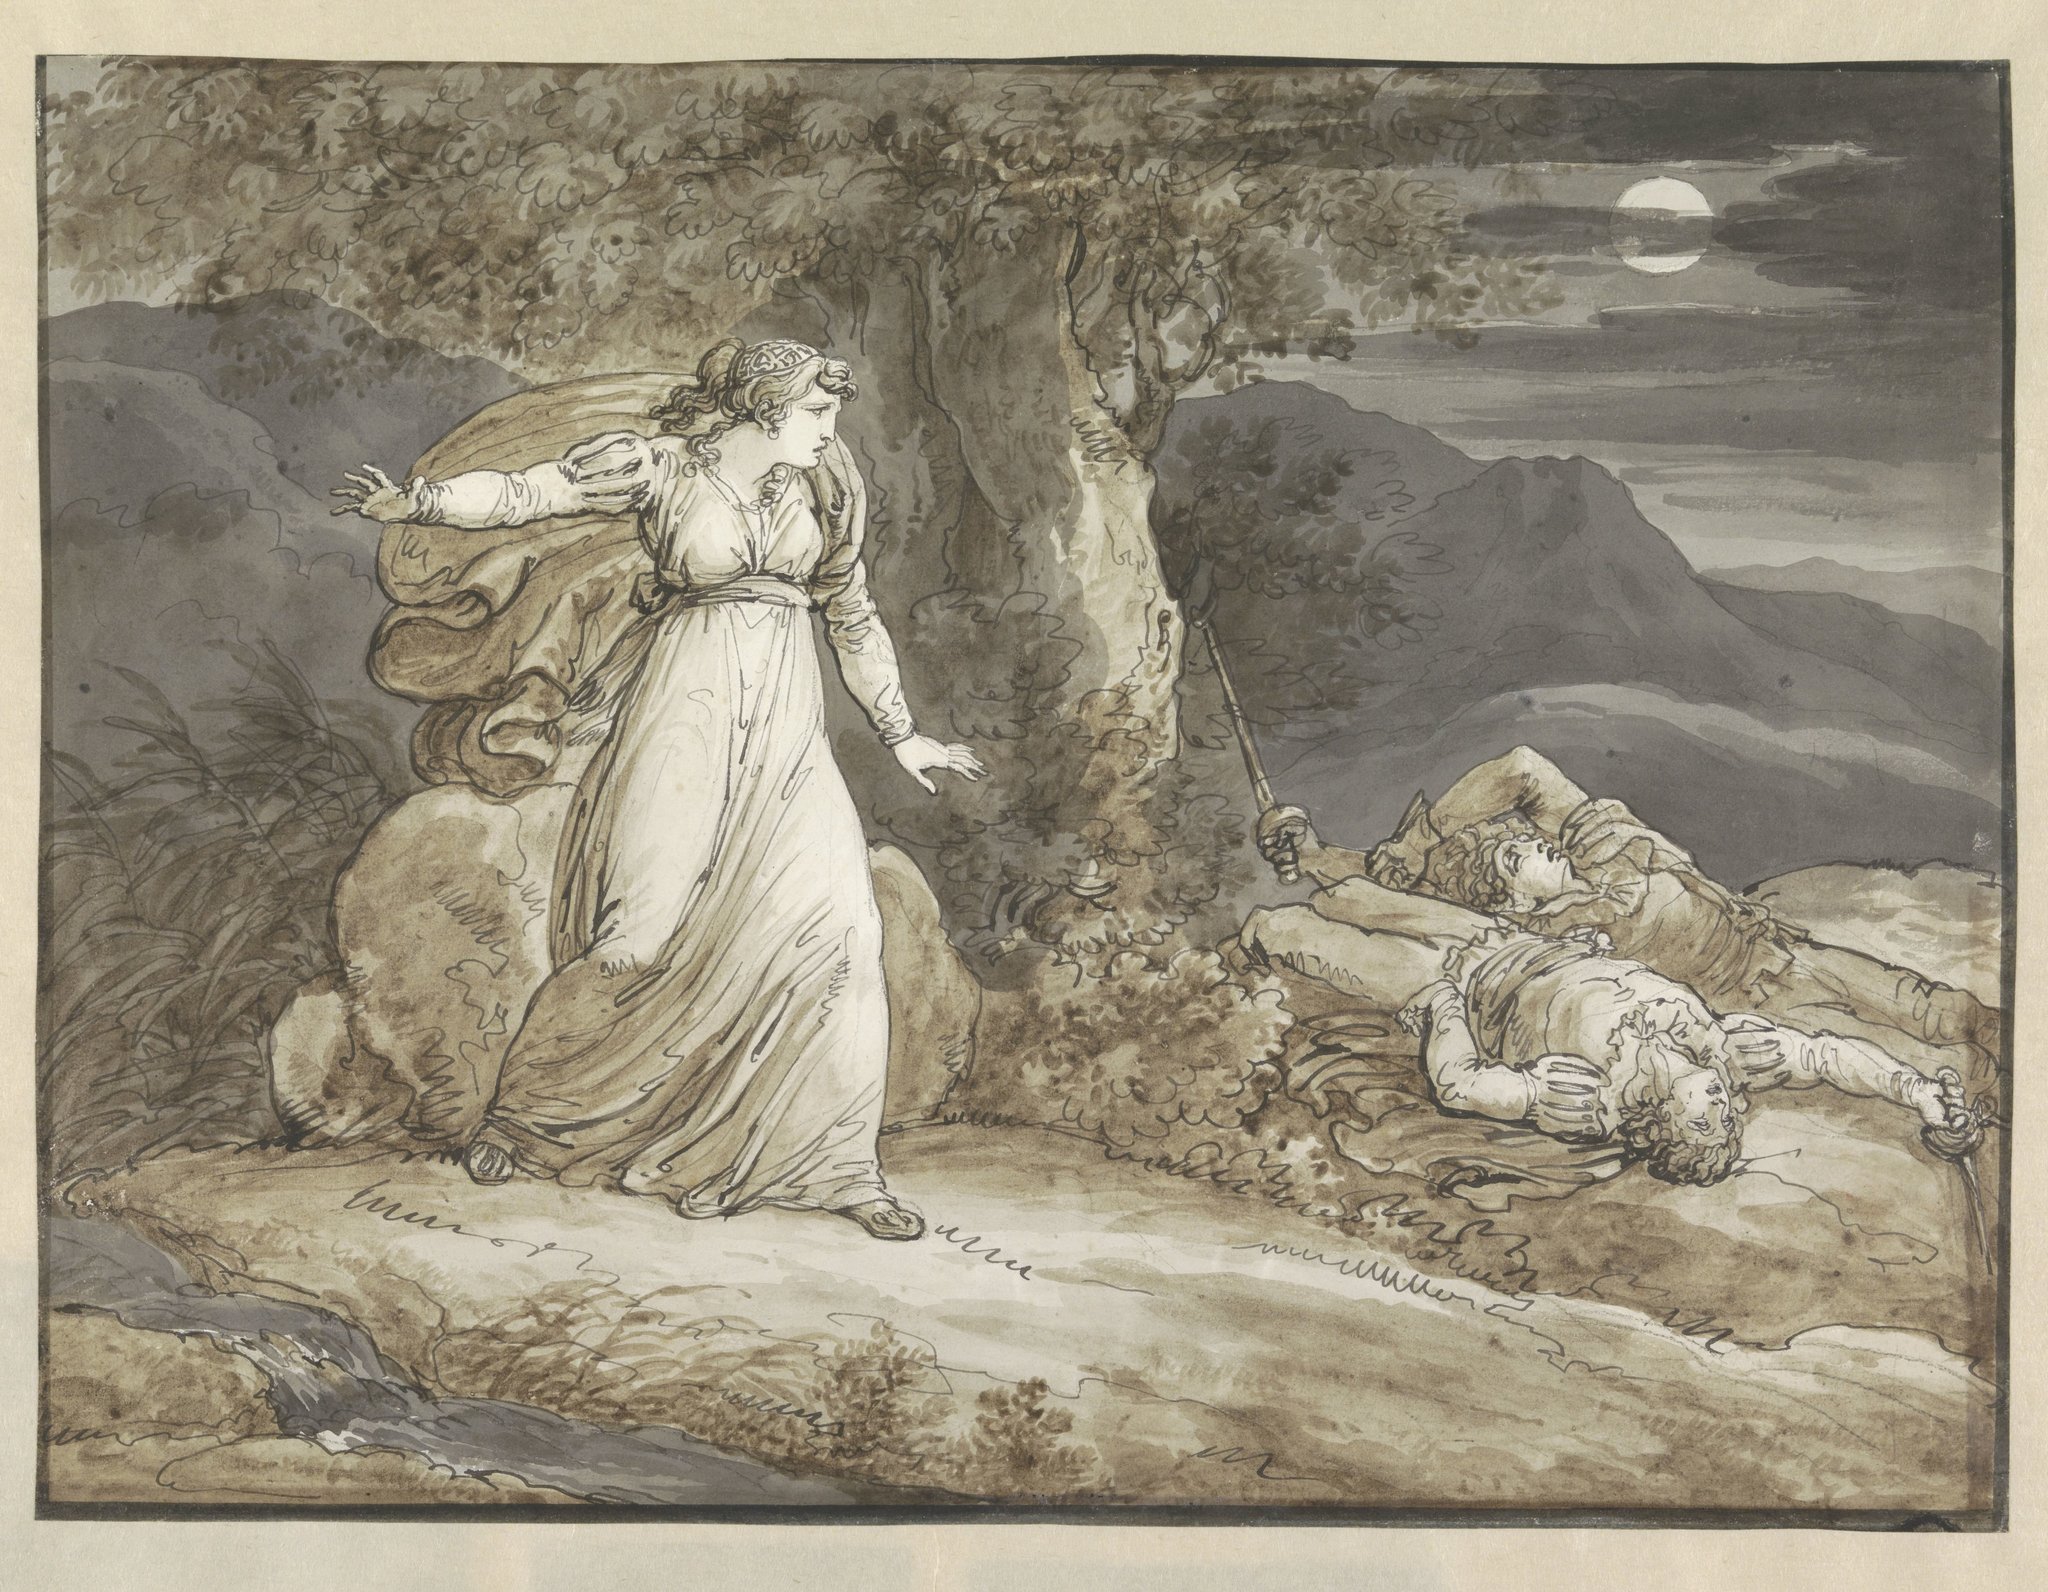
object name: drawing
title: Colma Discovering the Dead Bodies of Salgar and her Brother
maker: bartolomeo pinelli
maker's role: draughtsman, print maker, sculptor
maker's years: 1781-1835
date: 1809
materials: chalk, ink, paper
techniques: brush, pen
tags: (scenes from) specific works of literature (with author, title), 'the poems of ossian' : use 83(macpherson, poems of ossian)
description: Pinelli was best known for his illustrations of classical writings such as the Aeneid and the Divine Comedy. In 1809 he made several large drawings of scenes from the Ballads of Ossian, a sensational forgery from 1762 of Scottish-Gaelic epic poems supposedly from the 3rd century. Here the heroine Colma discovers the bodies of her brother and her lover Salgar, who had been dueling because of a protracted family feud.